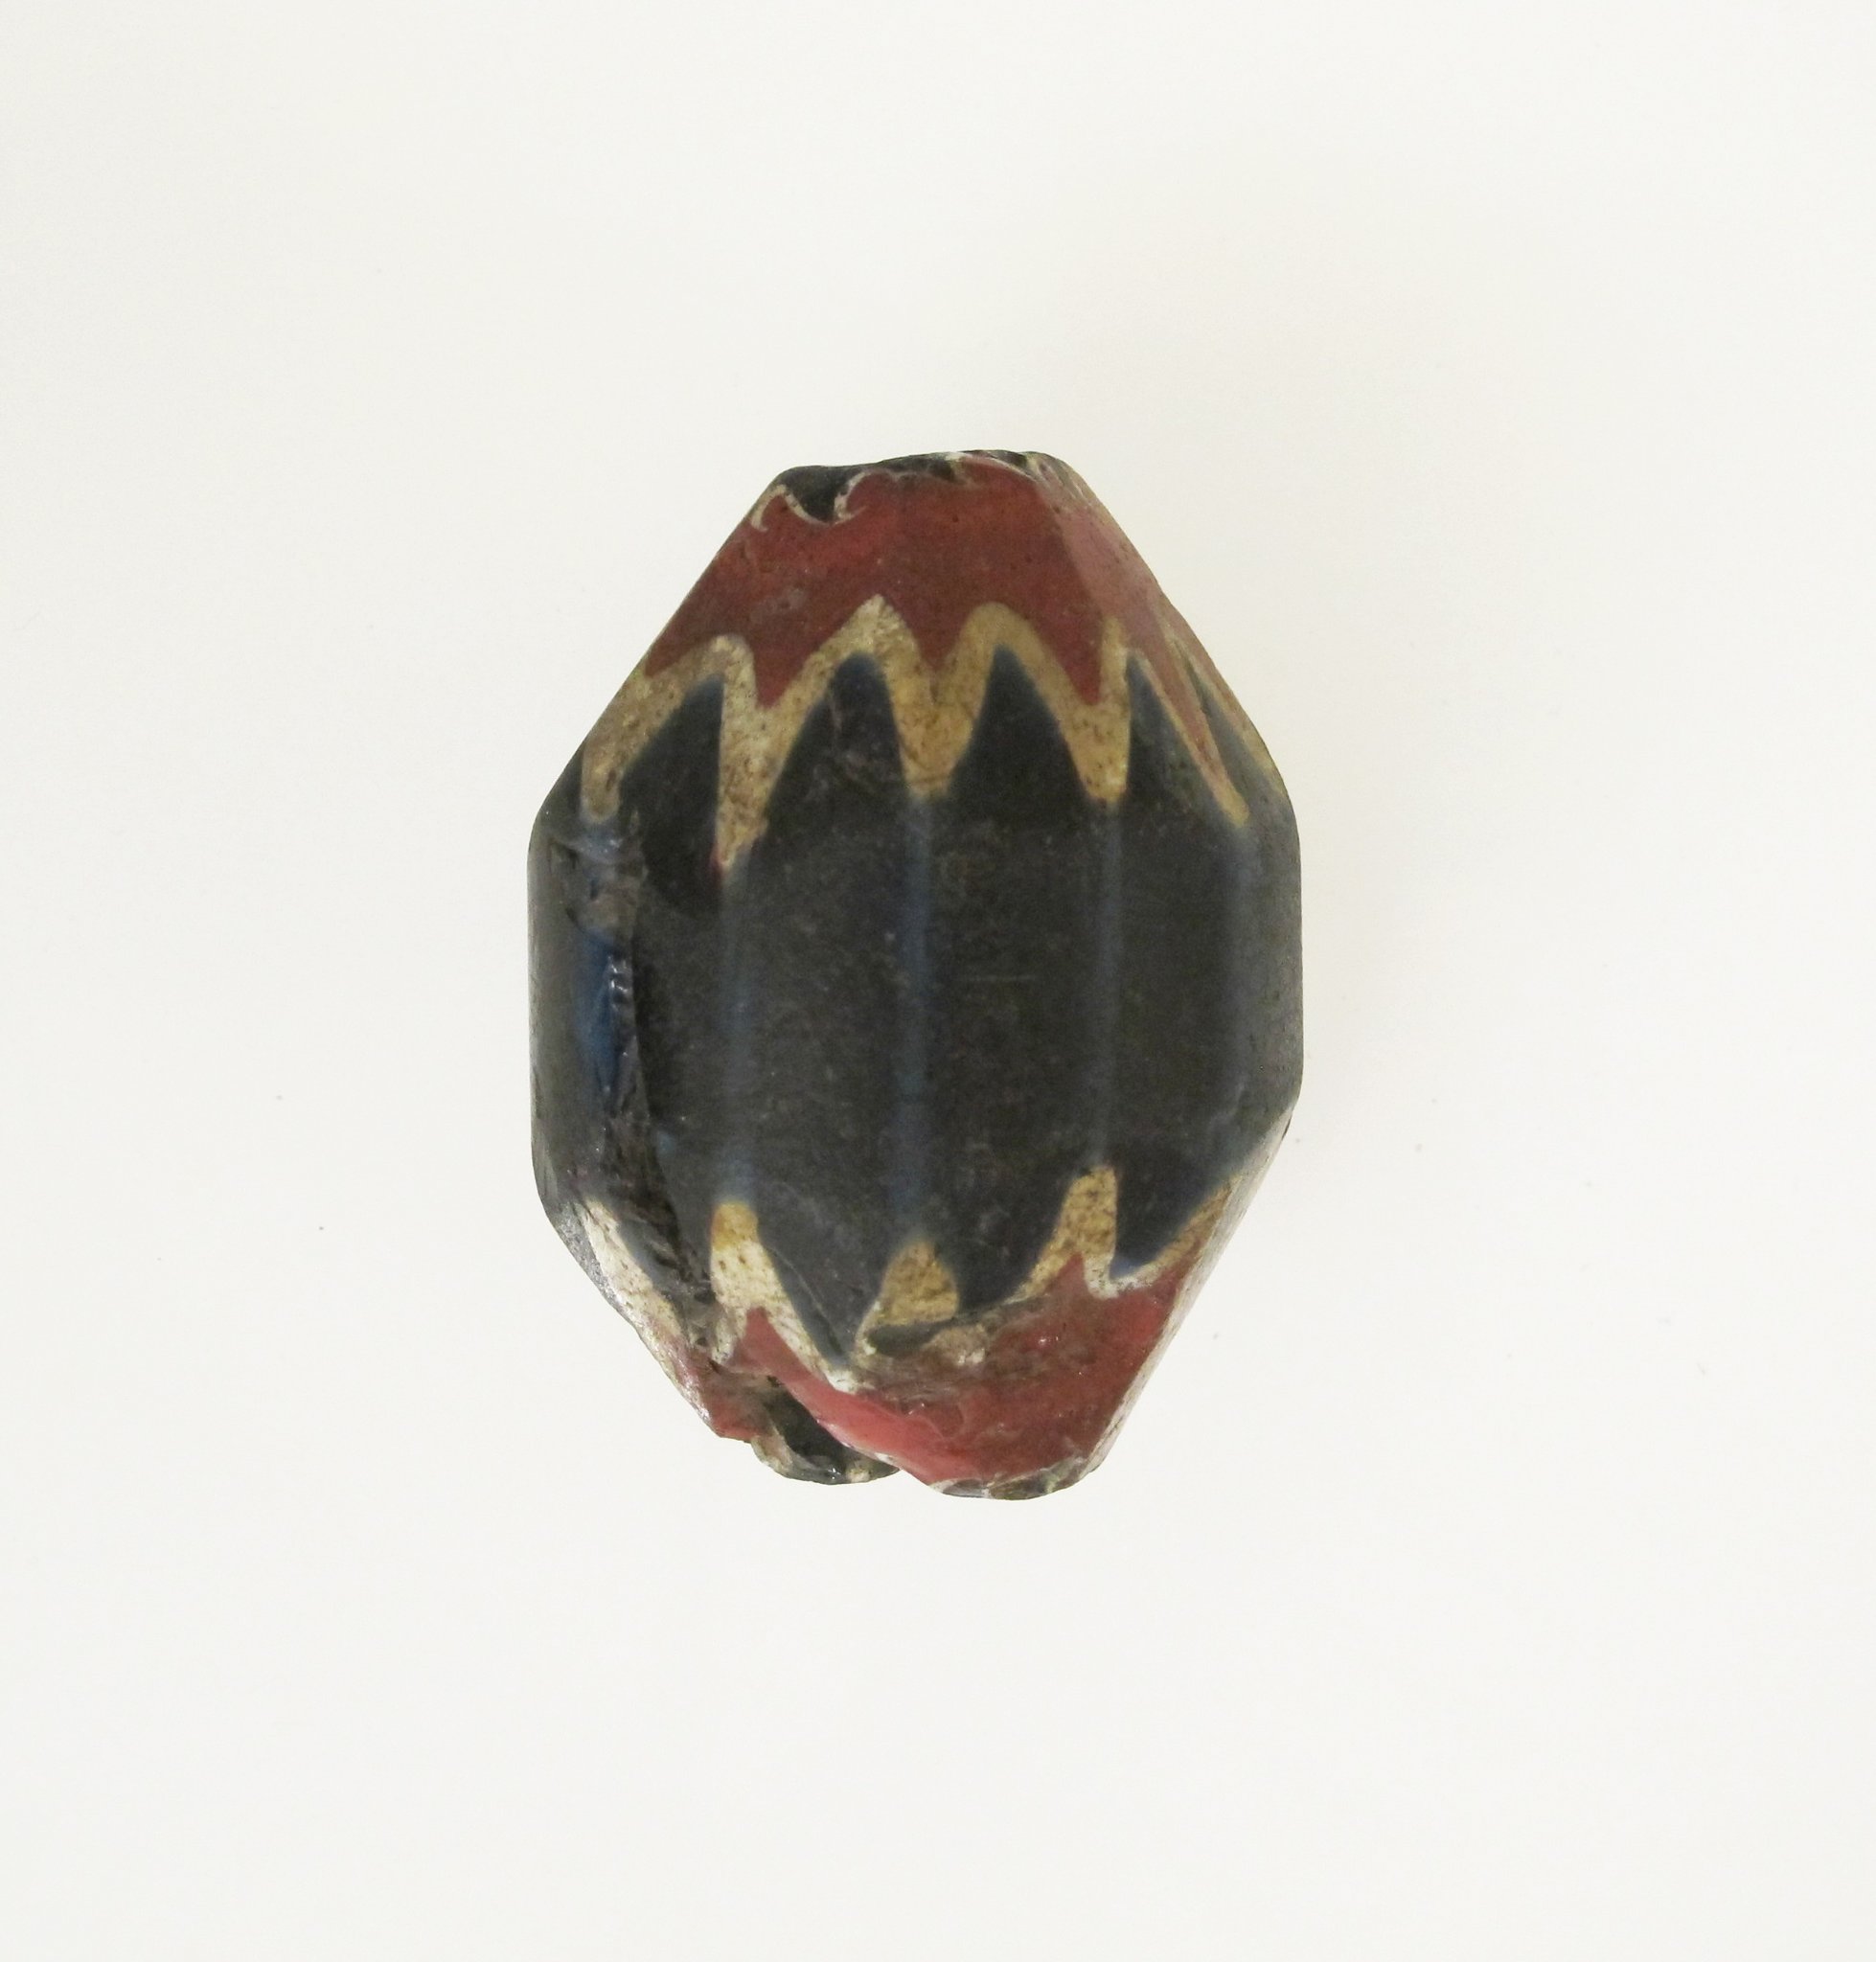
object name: millefiori bead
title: Glass chevron bead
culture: venetian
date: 1700-1799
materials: glass